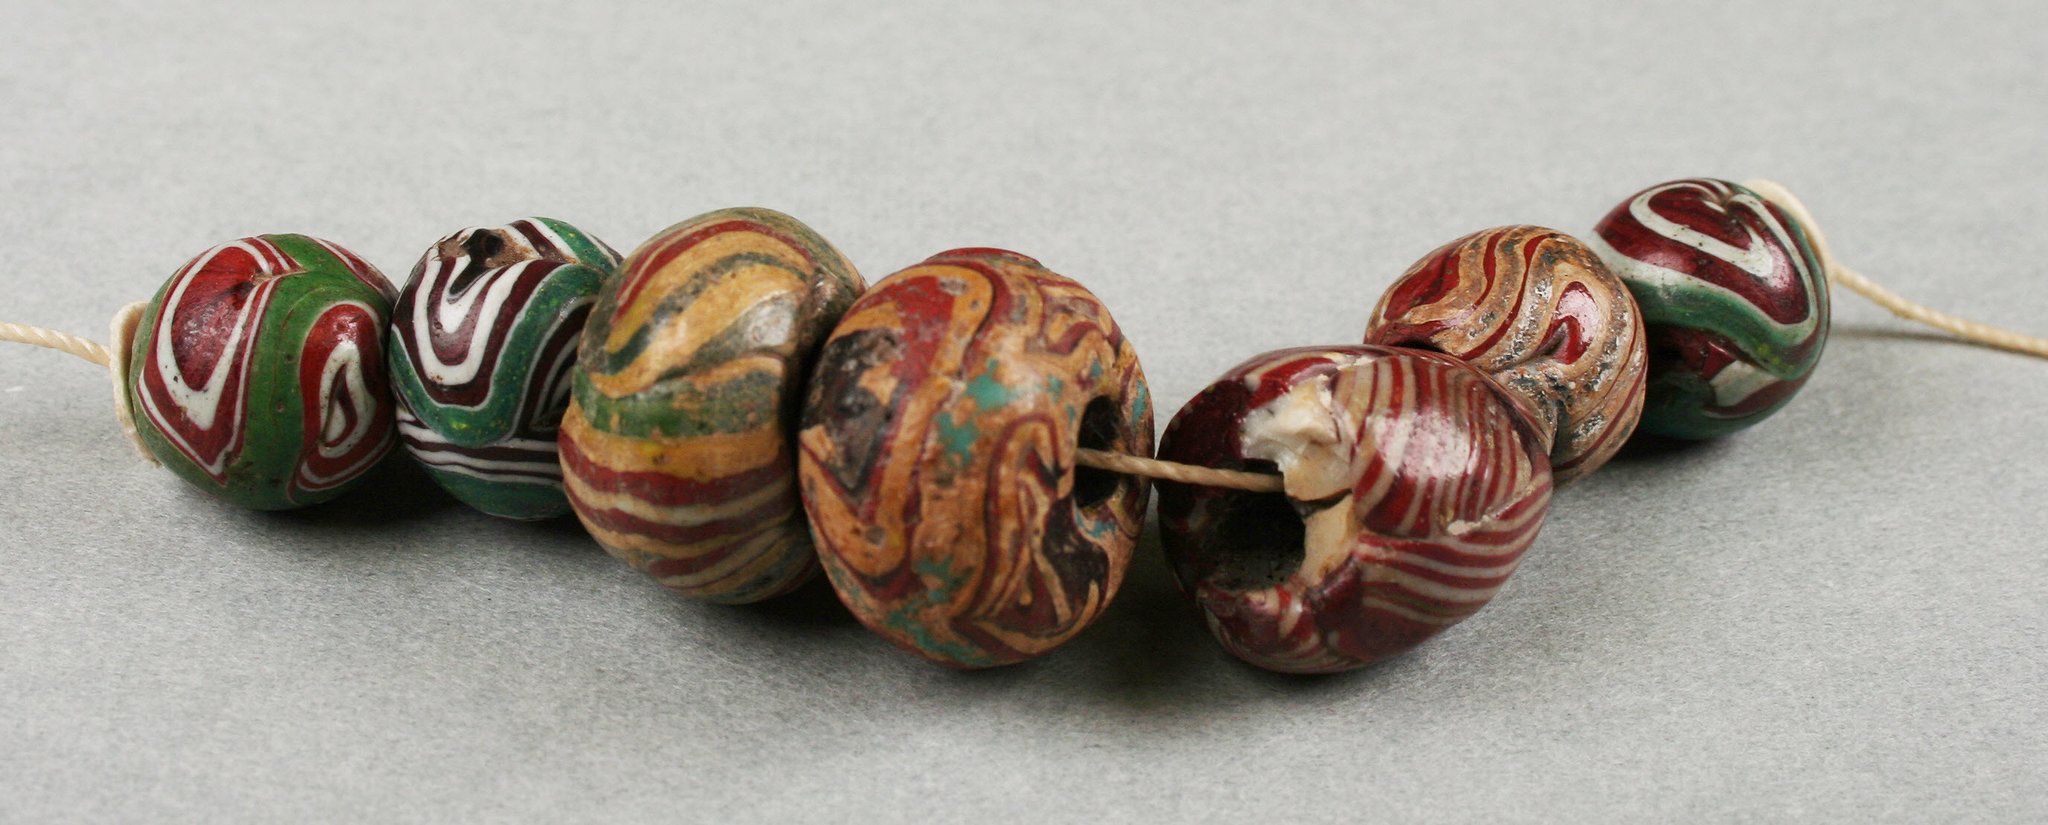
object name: bead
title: Beads, string of seven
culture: african or european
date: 1701-1800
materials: glass